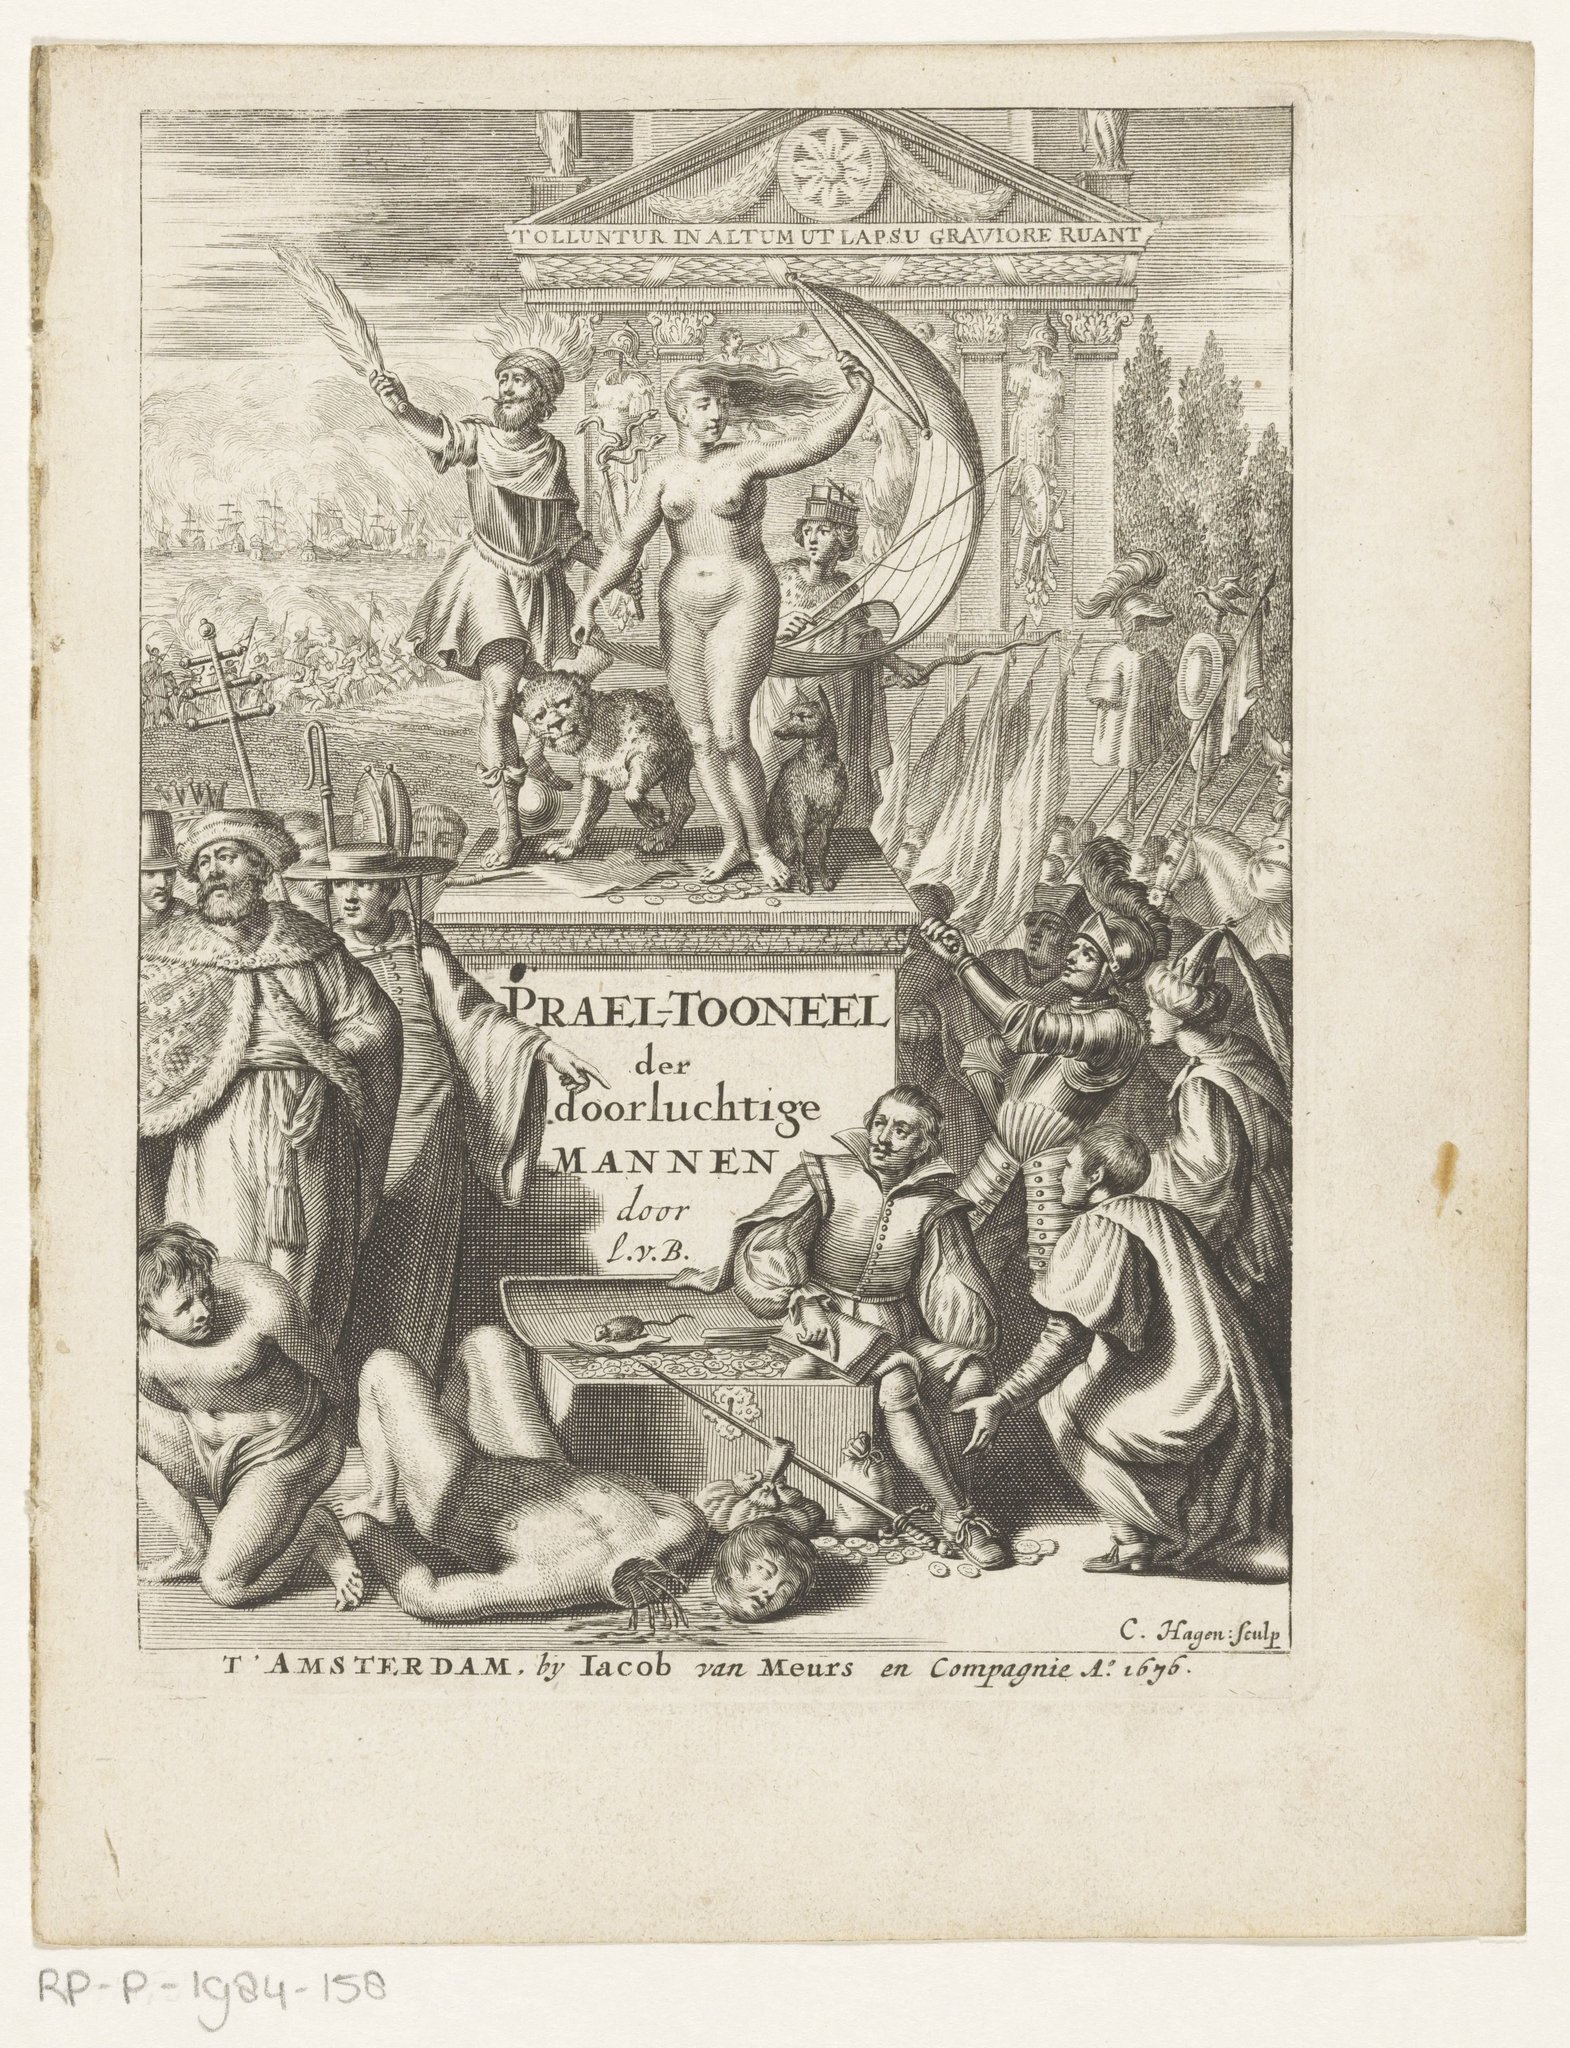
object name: titelblad, titelpagina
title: Titelpagina voor: Lambert van den Bos, Prael-Tooneel der doorluchtige Mannen, 1676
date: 1676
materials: paper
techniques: engraving, etching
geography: amsterdam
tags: luck, fortune, lot; 'fato', 'fortuna', 'fortuna aurea', 'fortuna buona', 'fortuna pacifica overo clemente', 'sorte' (ripa), standing figure - aa - female human figure, violent death by beheading, money-chest, treasure-chest, money-box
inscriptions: collector's mark: Lugt 2228, collector's mark: Lugt 2760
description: Een voetstuk in een landschap waarop een vrouwelijk naakt met een zeil, mogelijk Fortuna. Links van haar een man met vlammen rond zijn hoofd. Aan haar voeten een hond en een leeuw. Rond het blok vele wereldlijke en geestelijke figuren. Op de voorgrond een onthoofd naakt en een geldkist. In de achtergrond een klassiek bouwsel met een timpaan, waarop het opschrift: Tolluntur in altum ut lapsu graviore ruant. Daarachter soldaten en zeilschepen op zee.